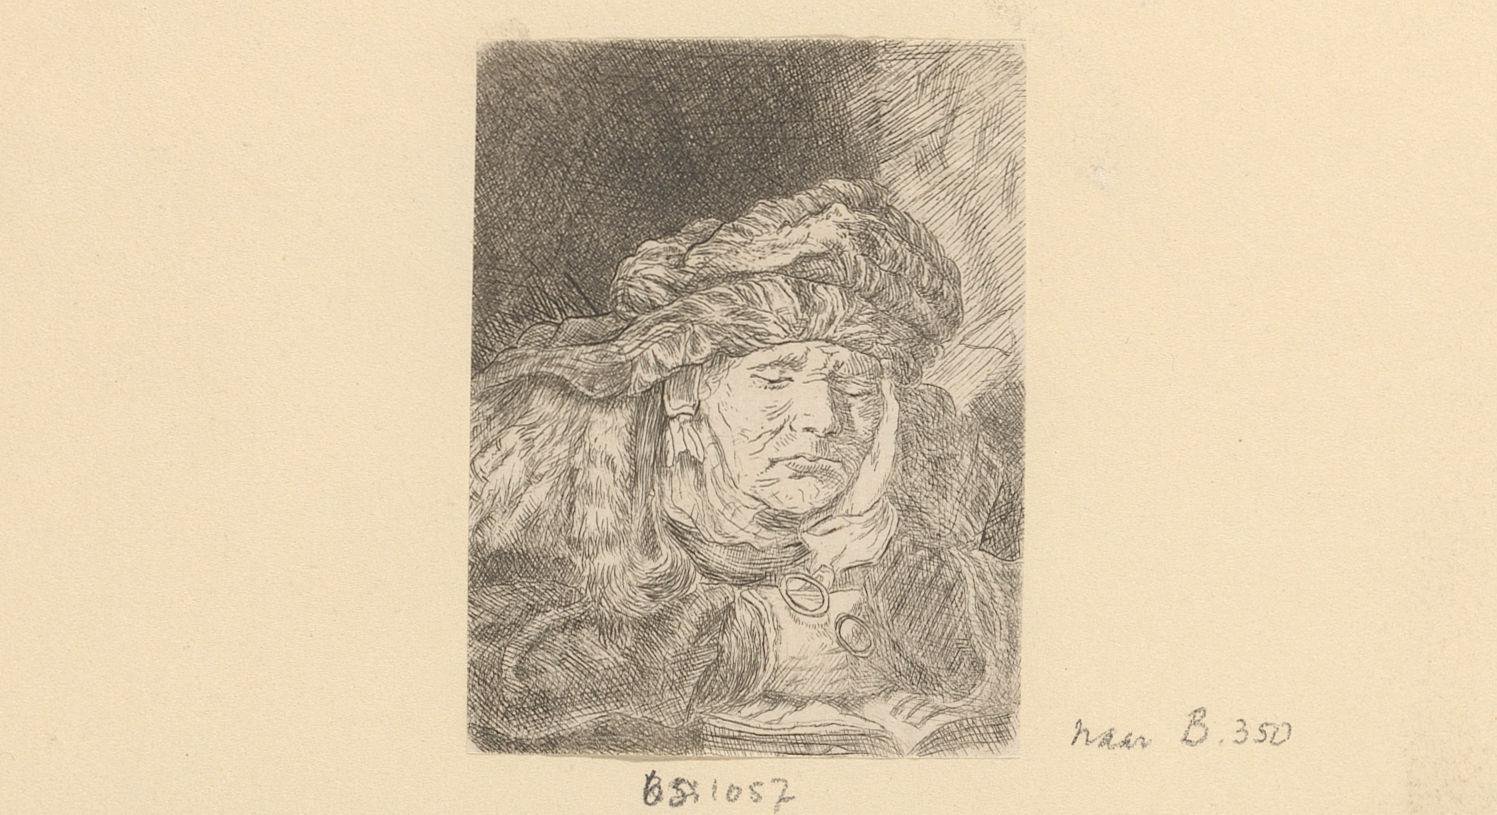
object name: album leaf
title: Old woman sleeping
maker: Anonymous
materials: paper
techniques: etching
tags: sleeping; unconsciousness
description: Kopie naar de gelijknamige prent van Rembrandt. Prent maakt mogelijk deel uit van een serie van 200 prenten. Deze serie is onder de titel 'A Collection of two hundred original etchings' voor het eerst uitgegeven door J.M. Greery in 1816.